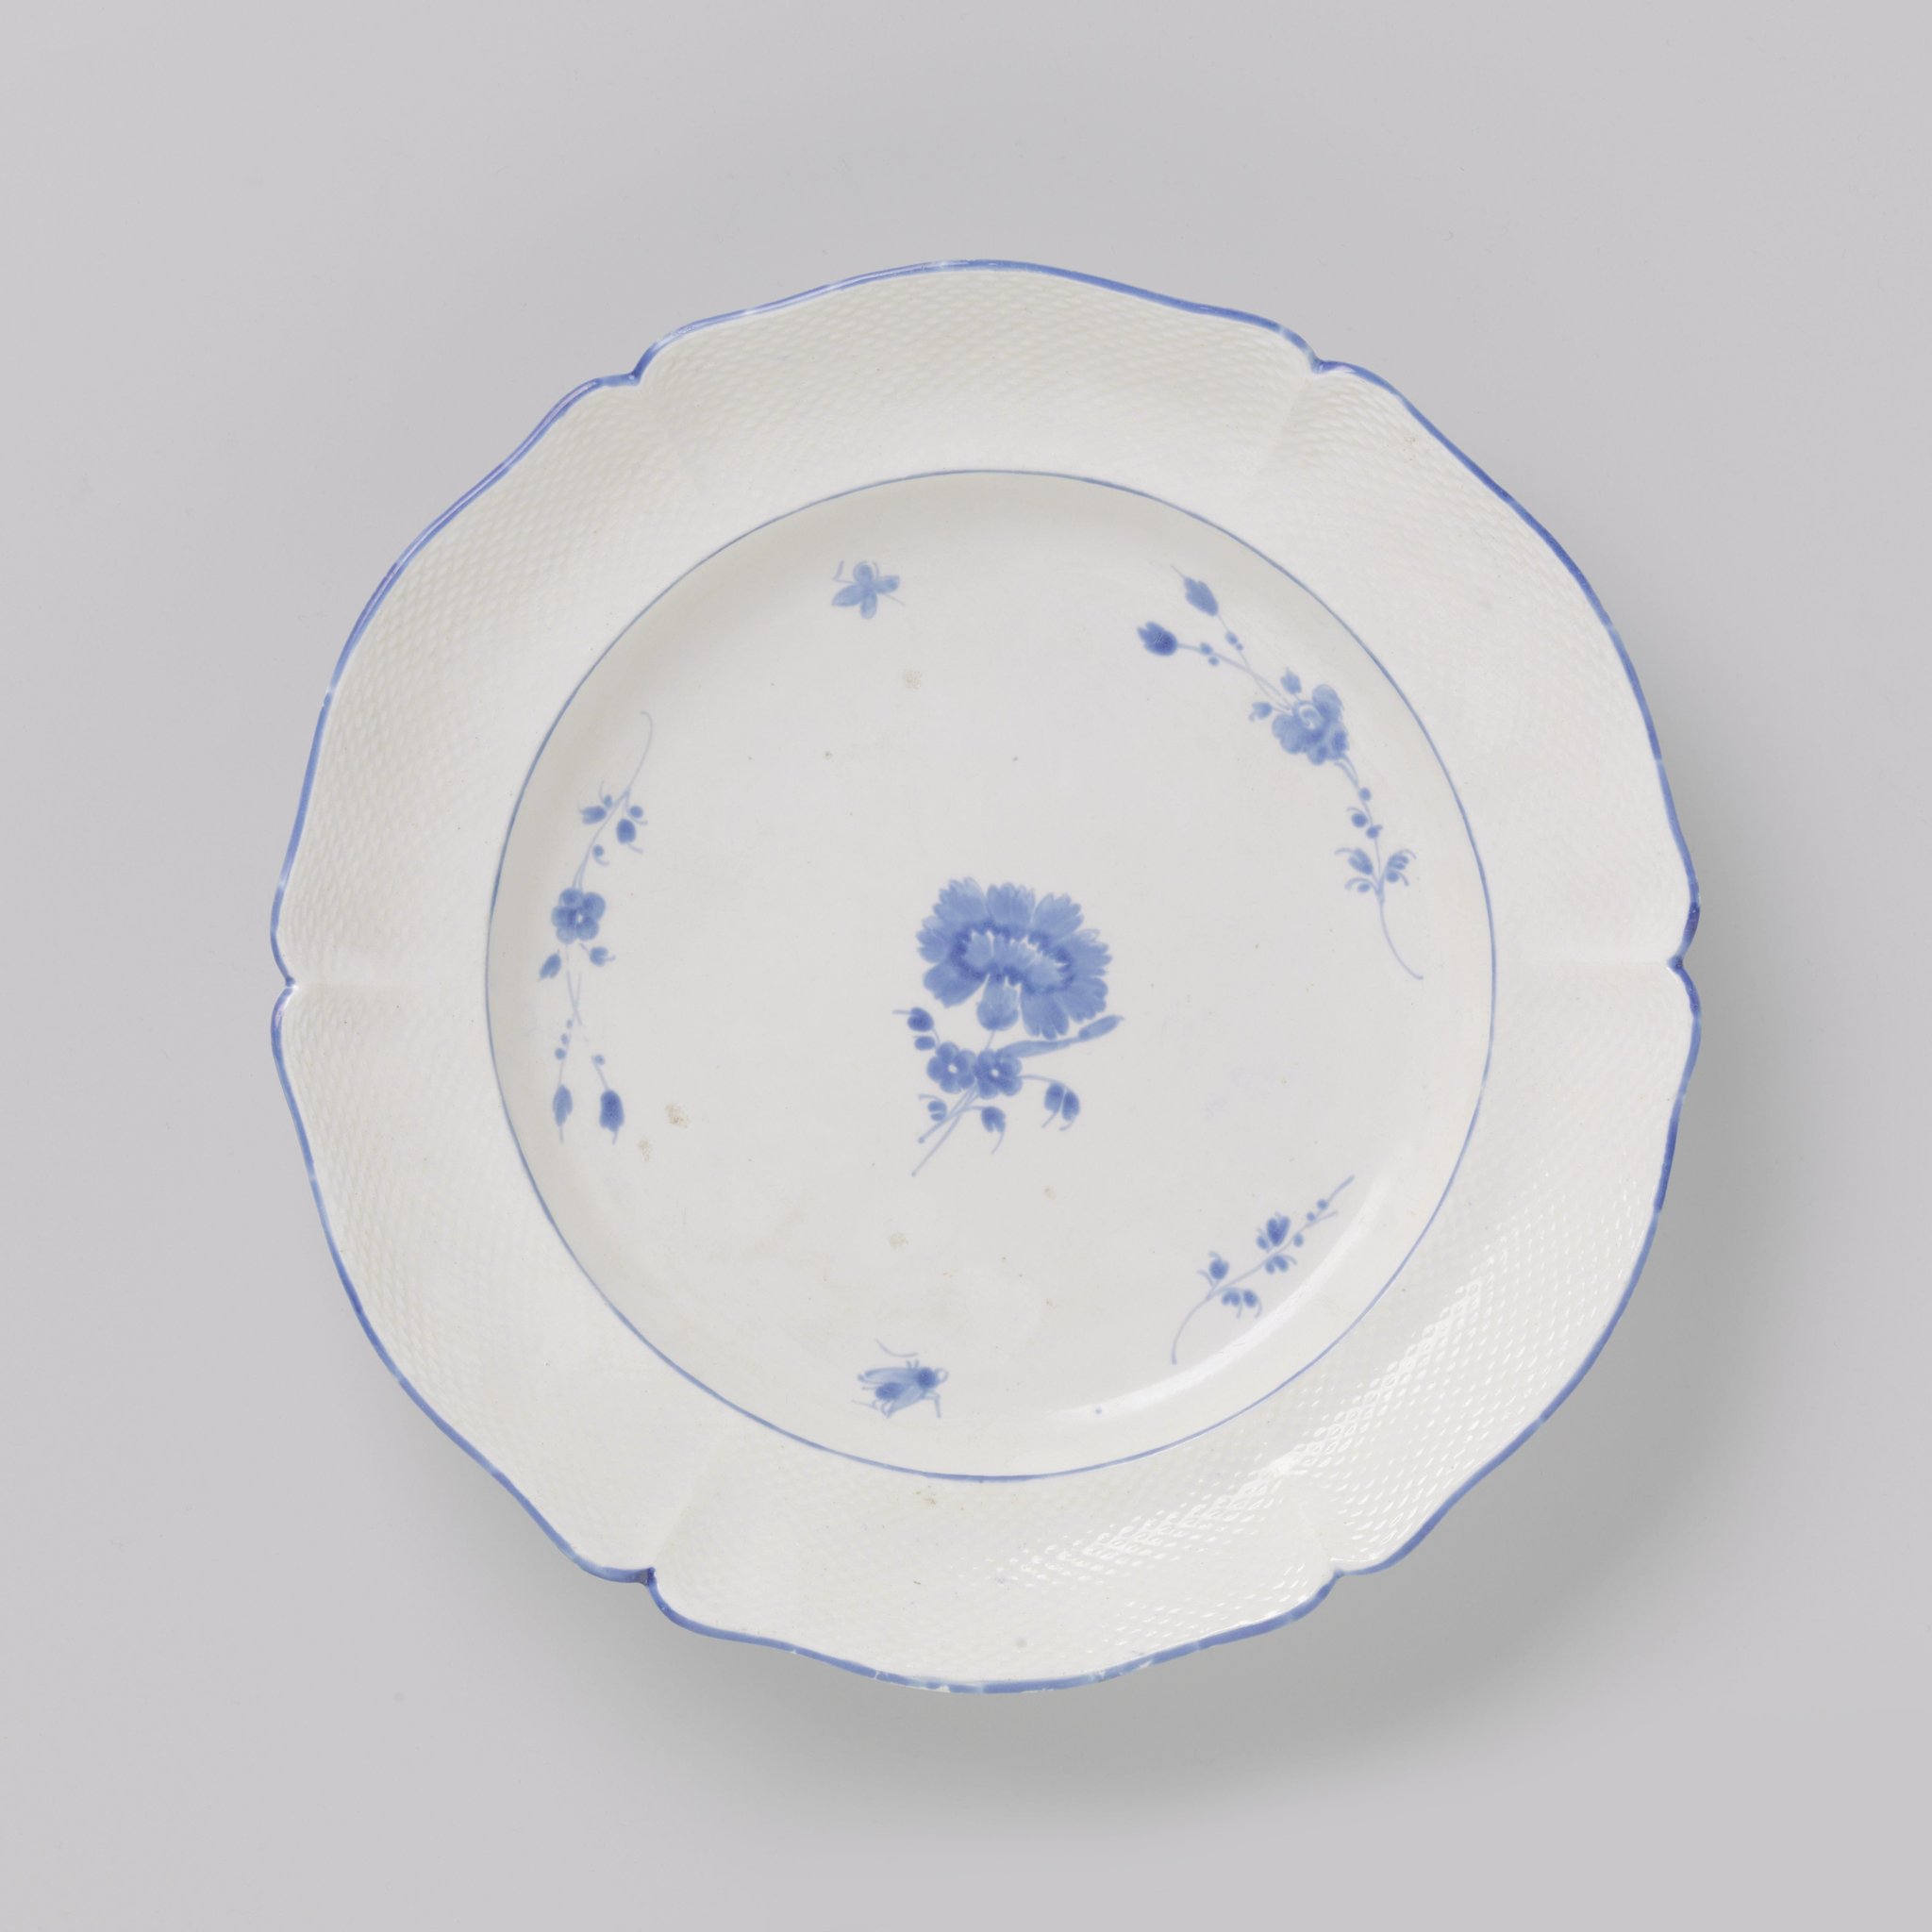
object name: platter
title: Dish with flower sprays and insects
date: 1790-1800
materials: cobalt, glaze, paint, porcelain, soft paste porcelain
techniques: firing, forming, turning, vitrification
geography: chantilly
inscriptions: mark: ‘H’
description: Schotel van soft-paste porselein (pâte tendre) met geschulpte rand, beschilderd in onderglazuur blauw. Op het plat een bloemtak omgeven door kleinere bloemtakken en insecten. De rand is gemodelleerd in zes vakken en versierd met vlechtwerk in reliëf. Gemerkt op de onderzijde met H.